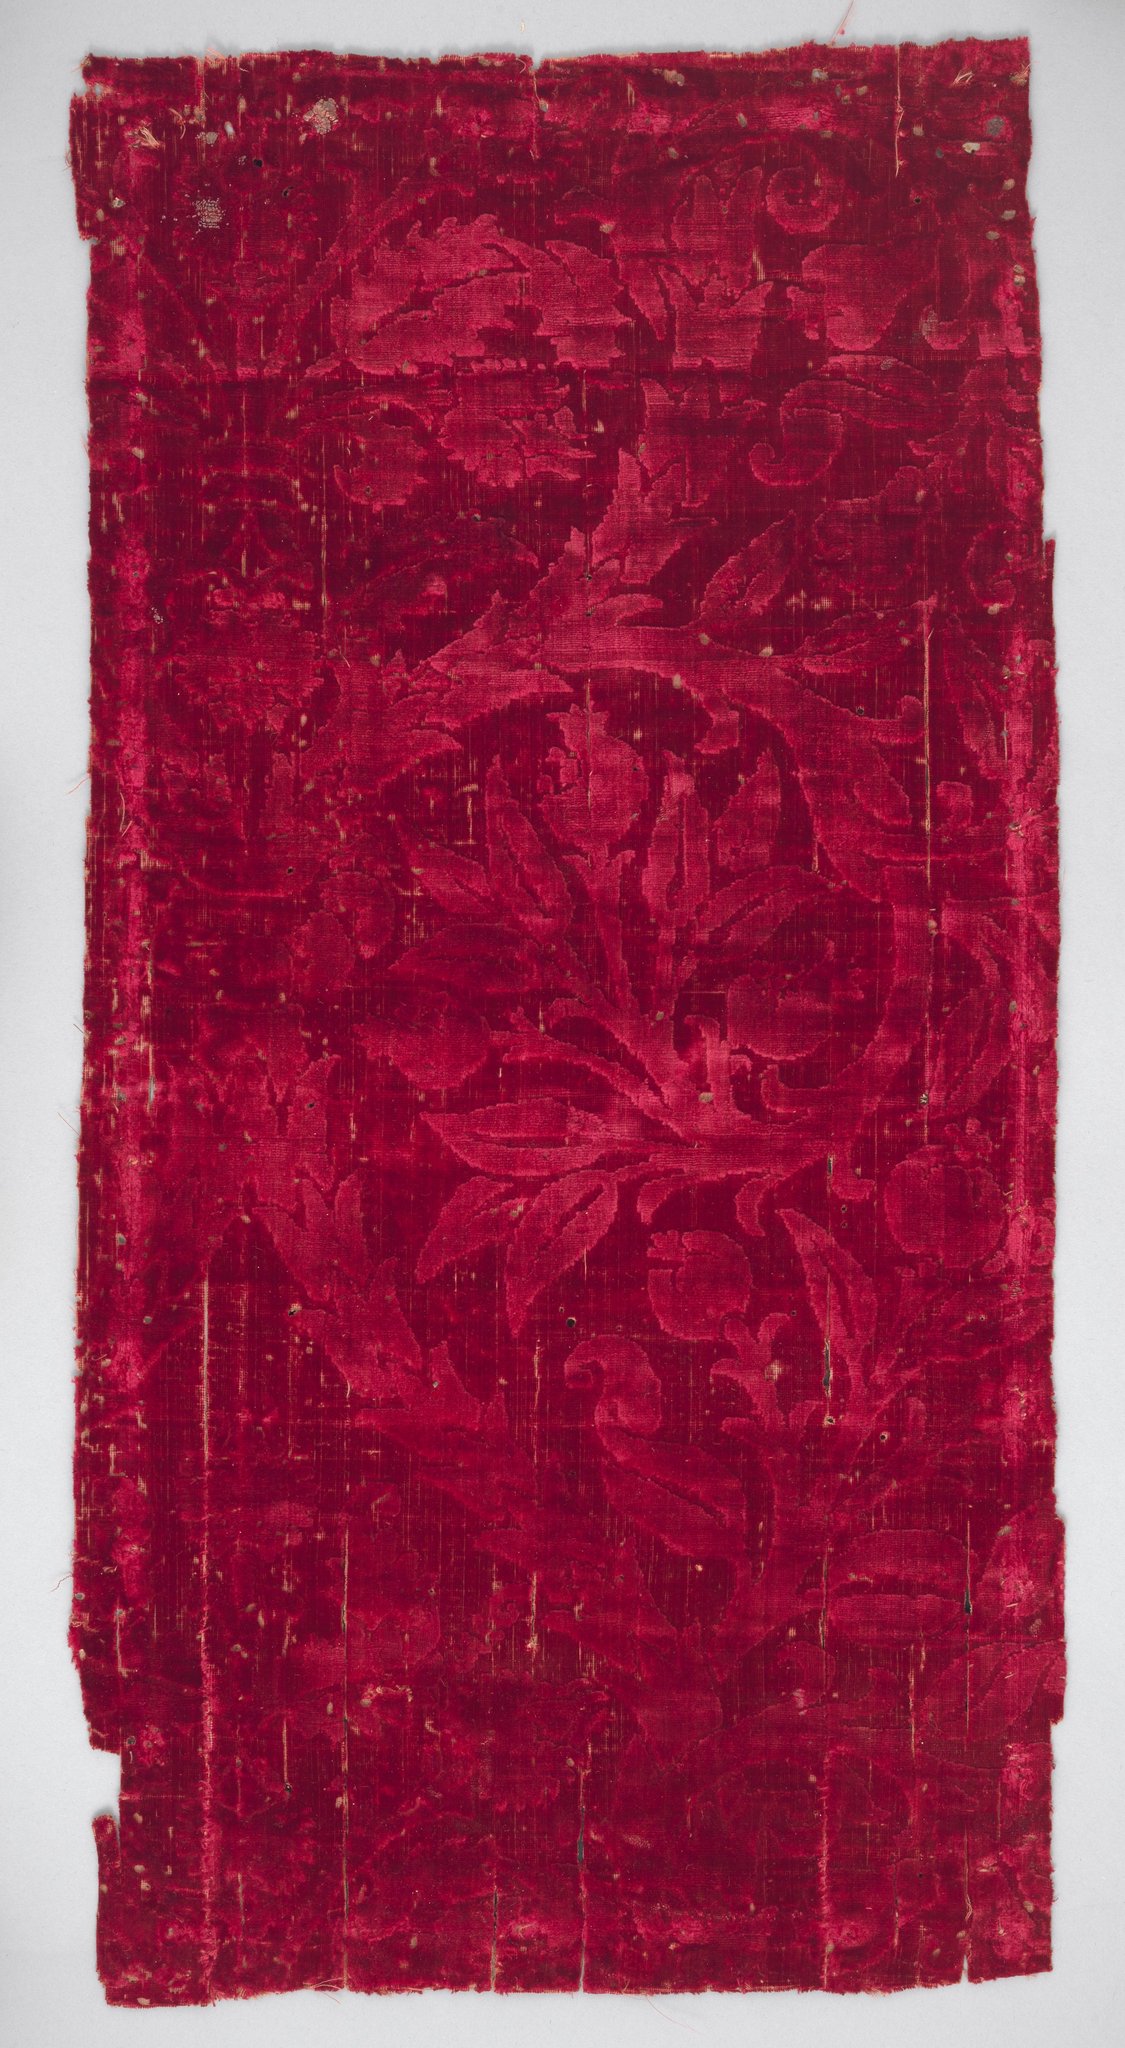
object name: piece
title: Fragment with Sempervivum tectorum motif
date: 1475-1525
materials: silk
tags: leaves